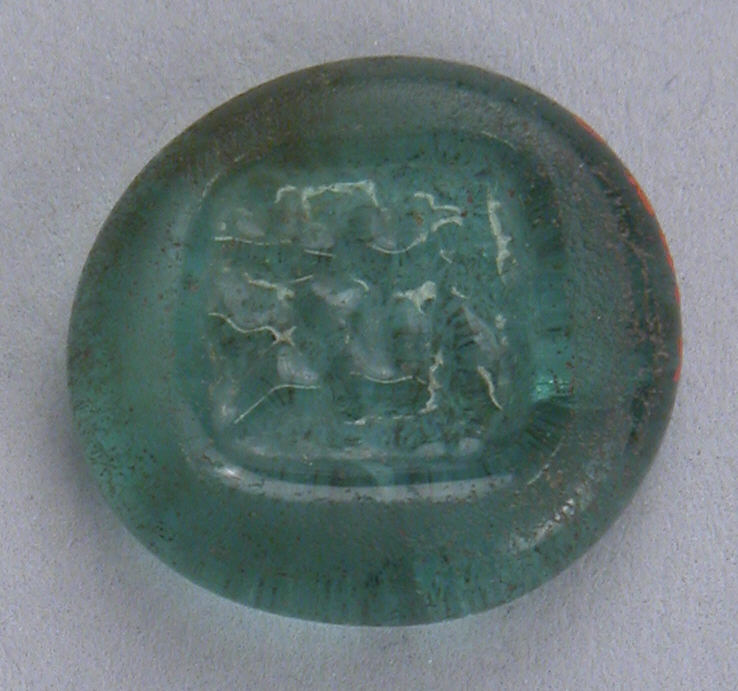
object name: coin weight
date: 1001-1100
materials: glass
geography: egypt